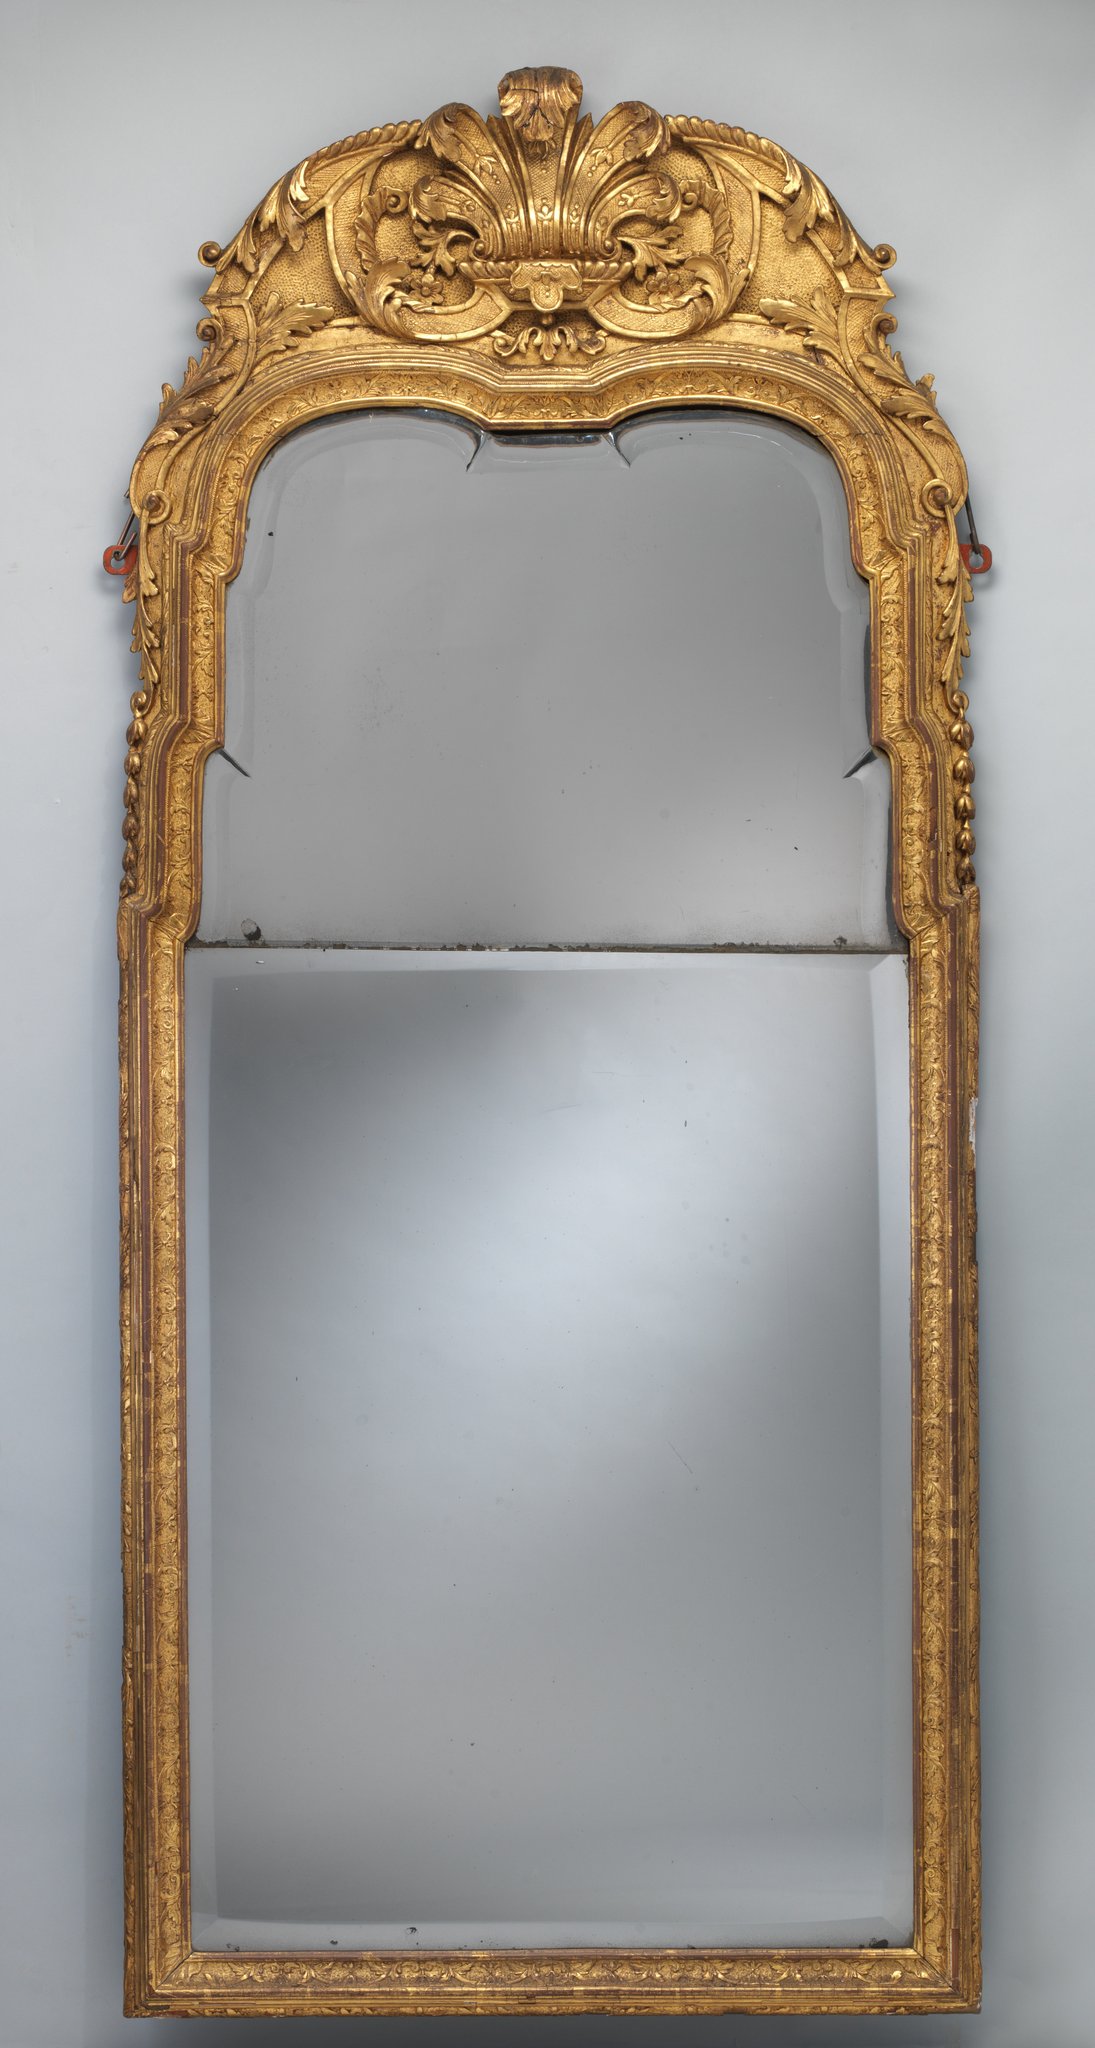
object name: mirror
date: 1720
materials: gesso, gilt, glass, wood